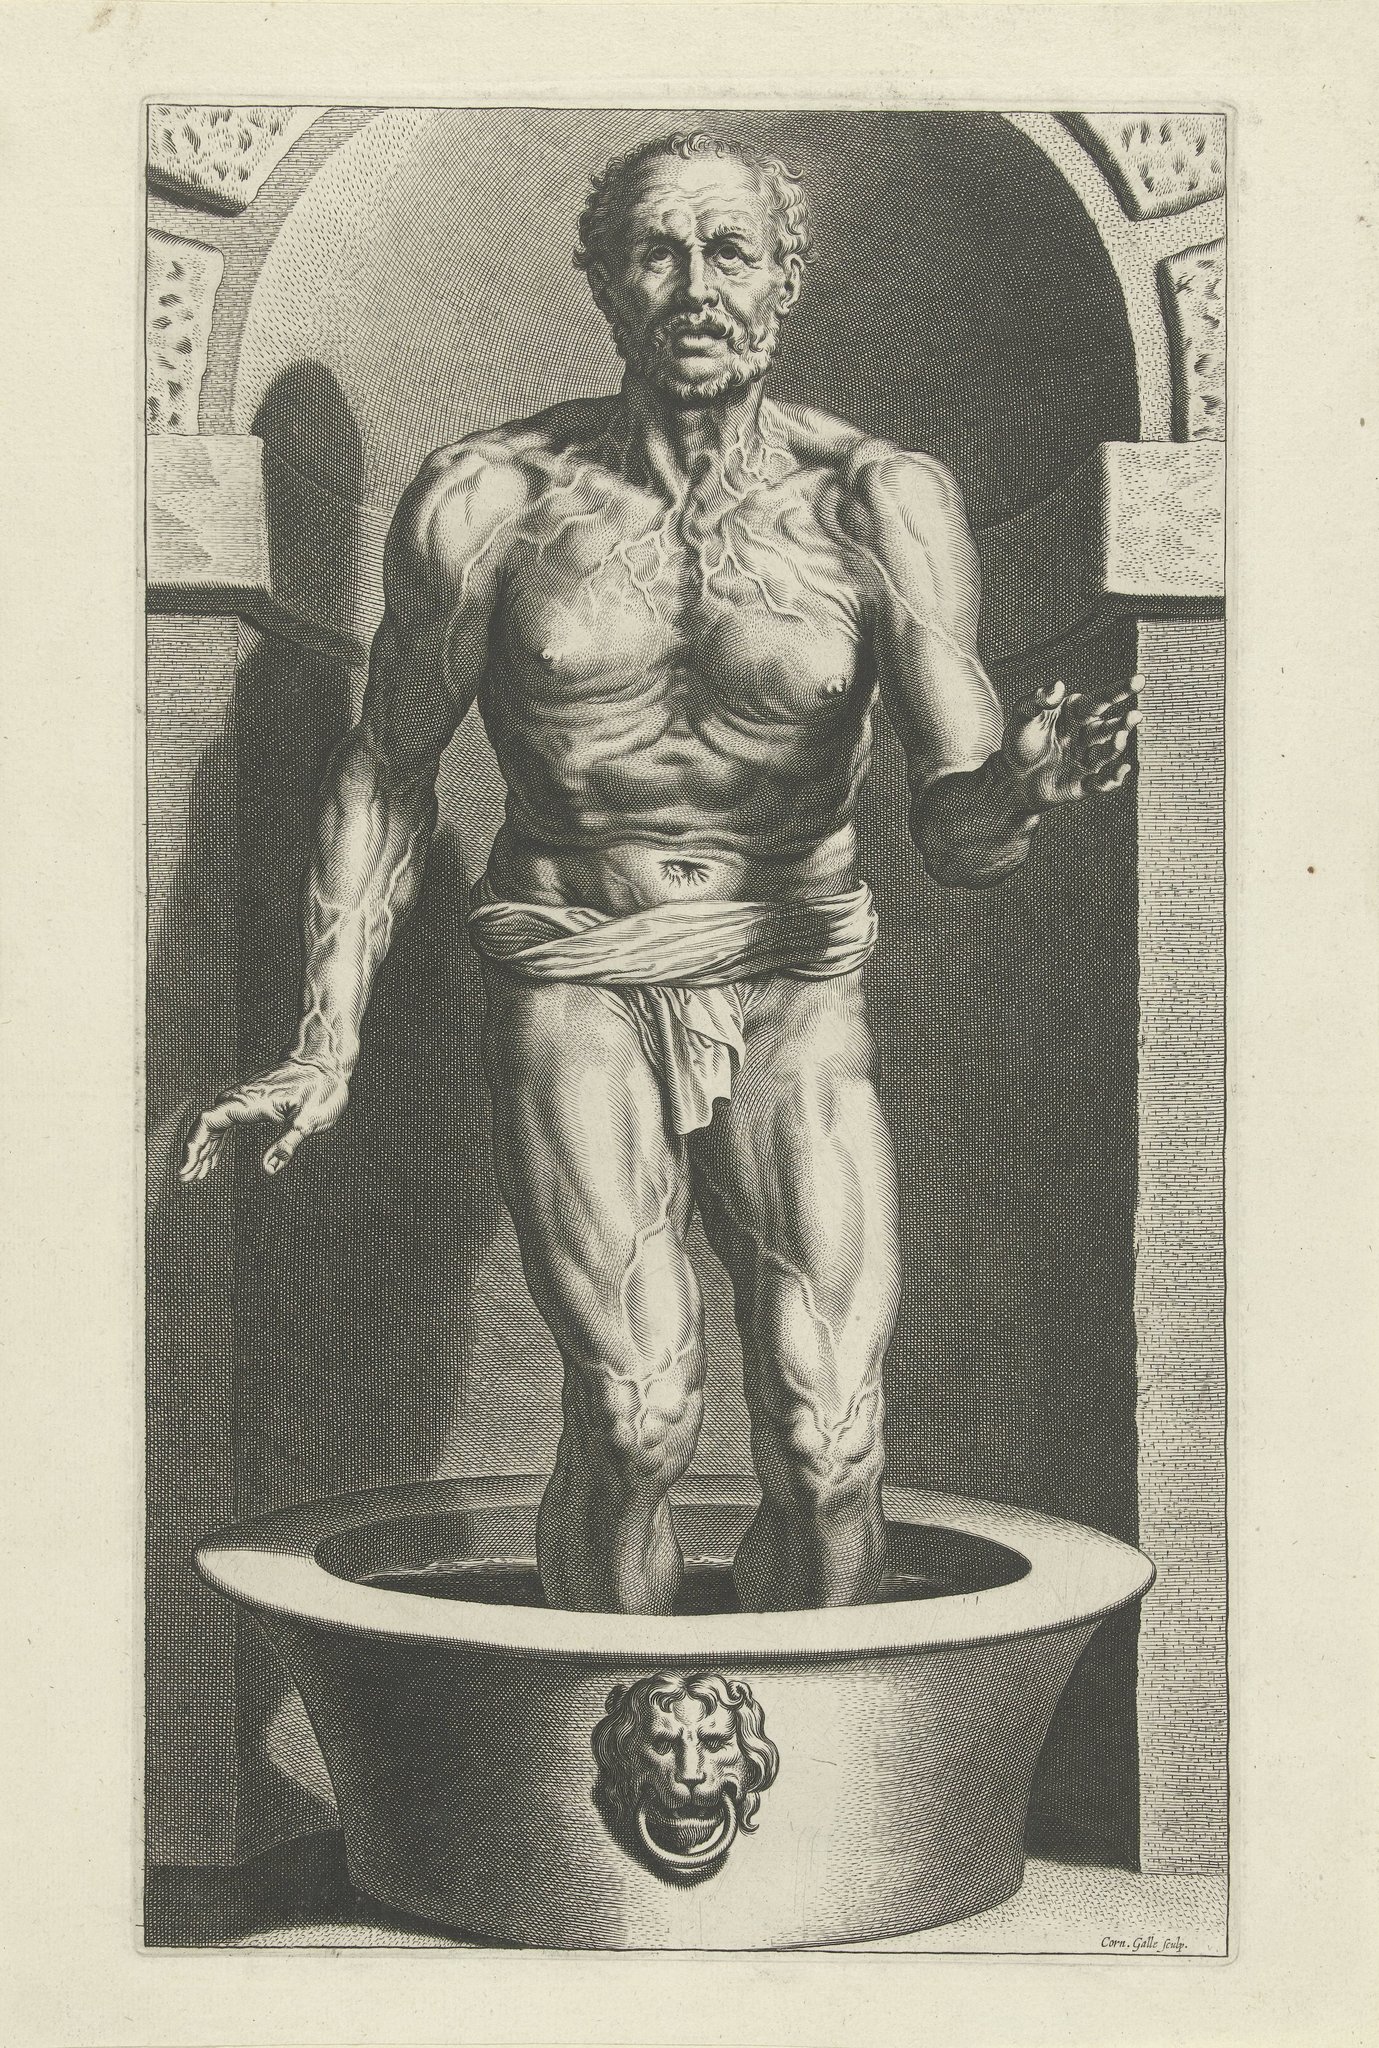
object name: print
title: Seneca staand, met zijn voeten in bad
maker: cornelis galle (i)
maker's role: print maker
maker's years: 1576-1650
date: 1586-1650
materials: paper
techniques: engraving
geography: southern netherlands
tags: death of seneca: at nero's order he cuts his veins, usually sitting in a basin or bath of water, and then takes a dose of poison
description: Beeld van de filosoof Seneca met zijn voeten staande in een bad. Zijn aders zijn duidelijk zichtbaar. Het beeld is in een nis geplaatst. Op het bad een leeuwenmuil.